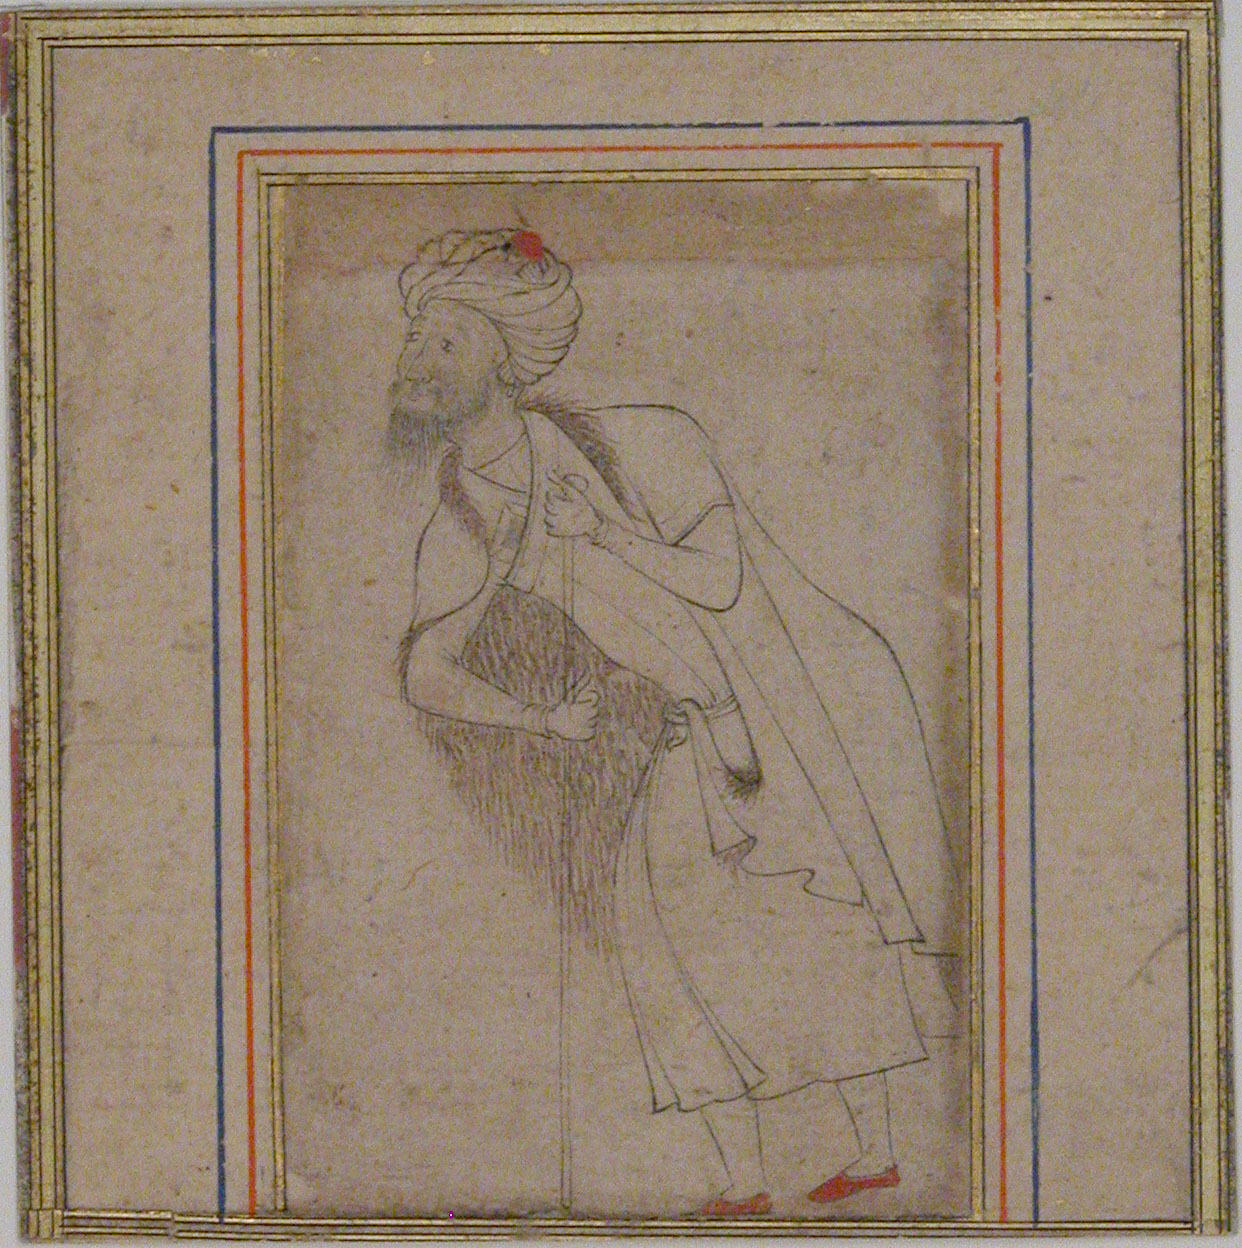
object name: illustrated single work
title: Dervish Leaning on a Staff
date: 1501-1600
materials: gold, ink, paper, watercolor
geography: iran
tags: men